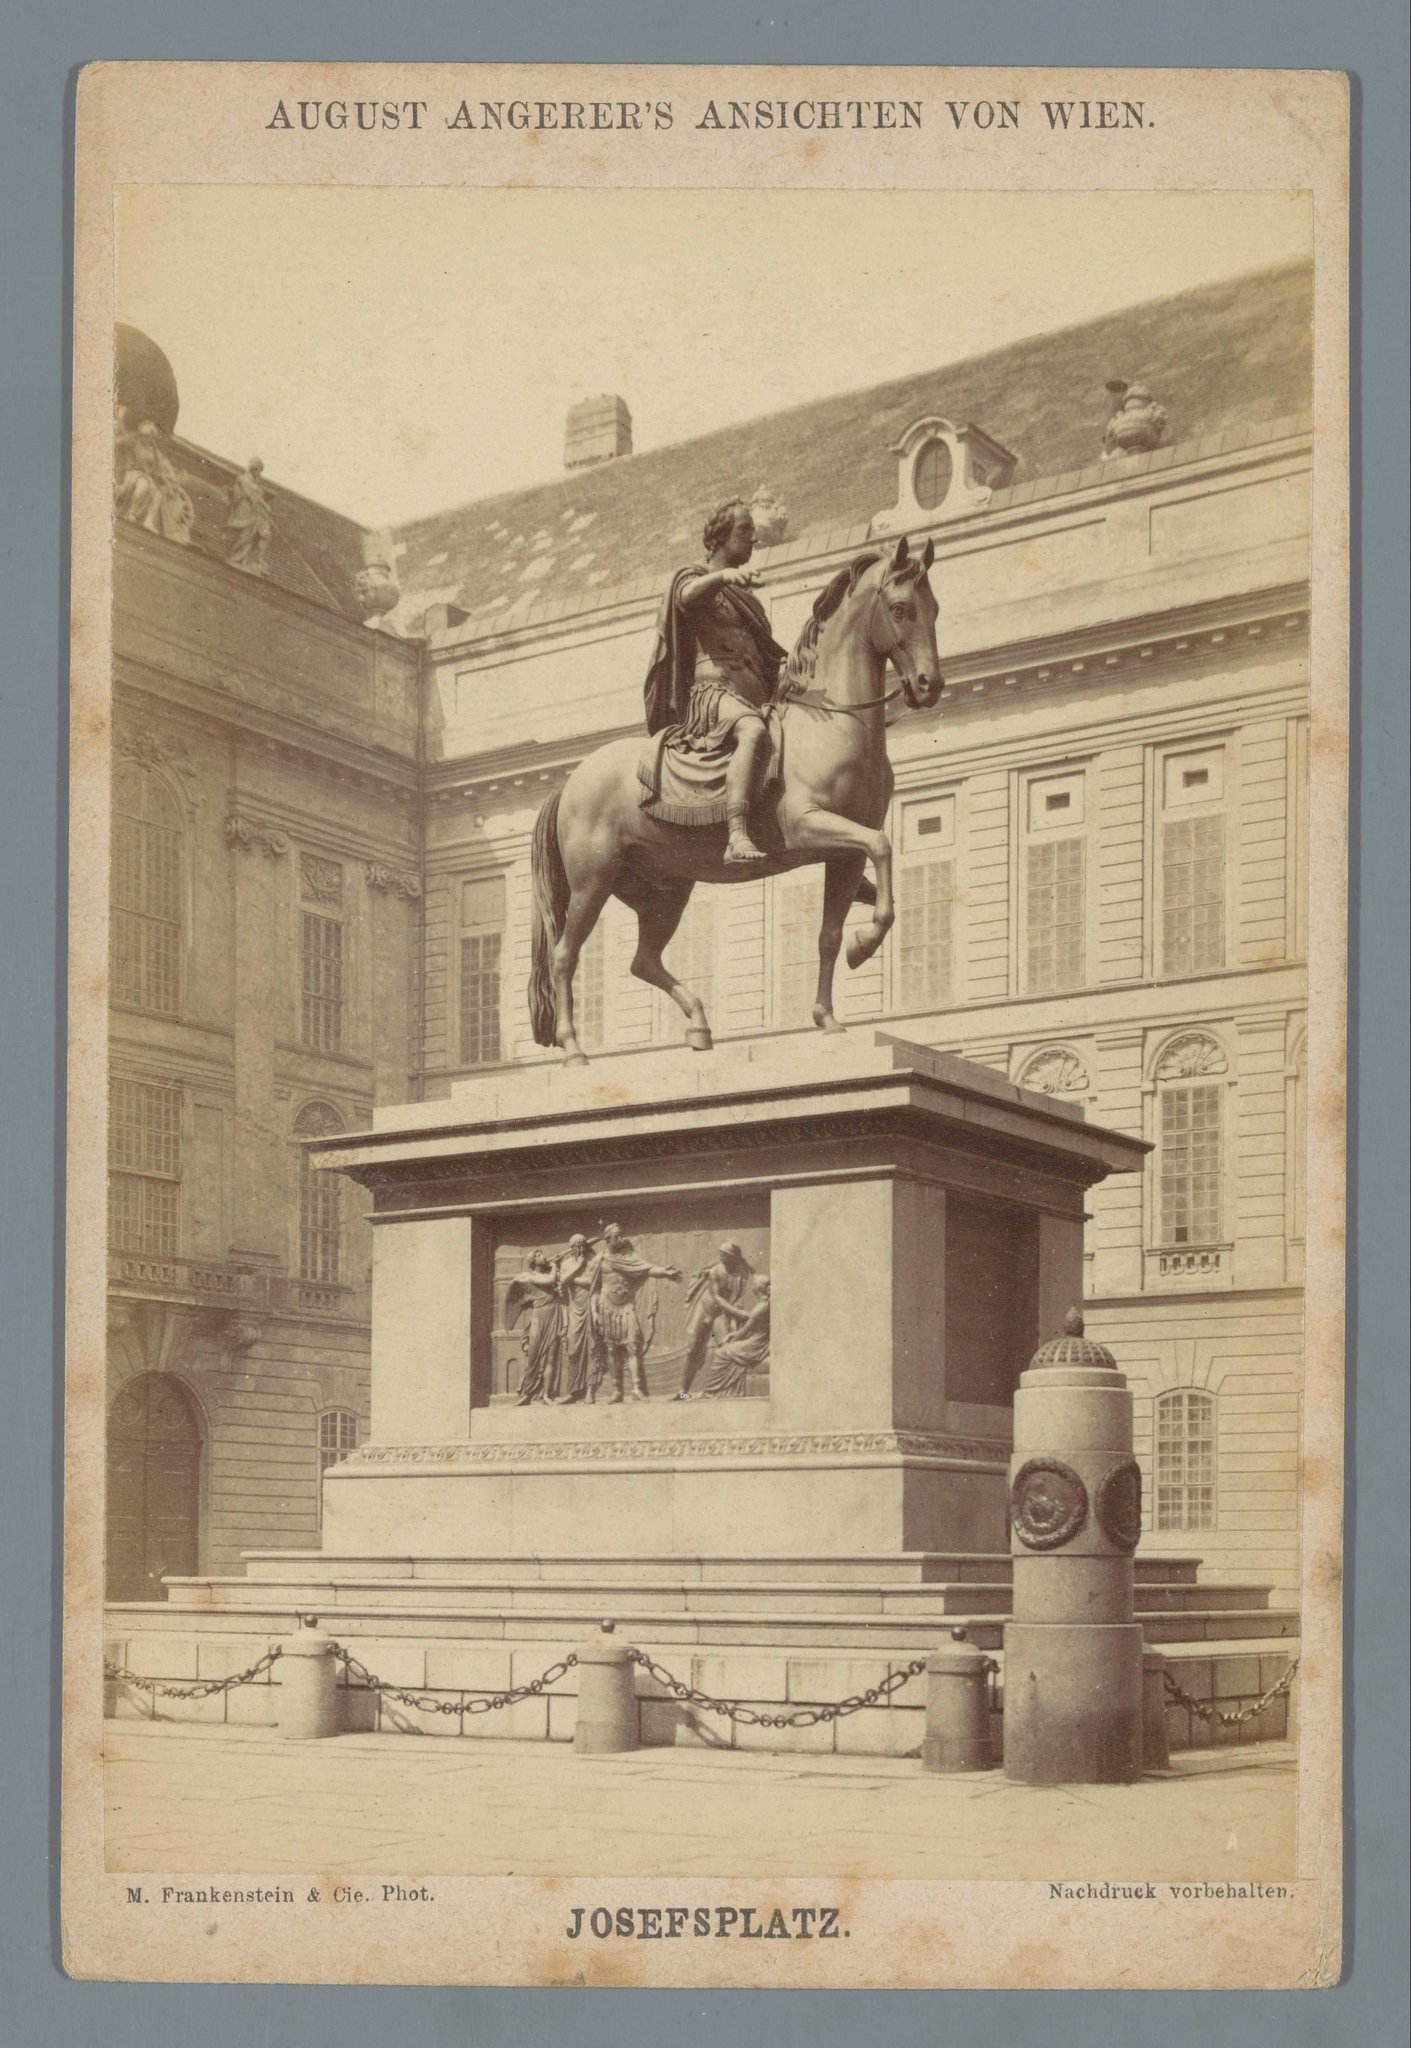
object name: photograph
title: Gezicht op het Josefsplatz in Wenen met ruiterstandbeeld van Jozef II door Franz Anton Zauner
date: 1875-1885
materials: cardboard, photographic support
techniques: albumen print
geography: vienna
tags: jozef ii (duits keizer), equestrian statue